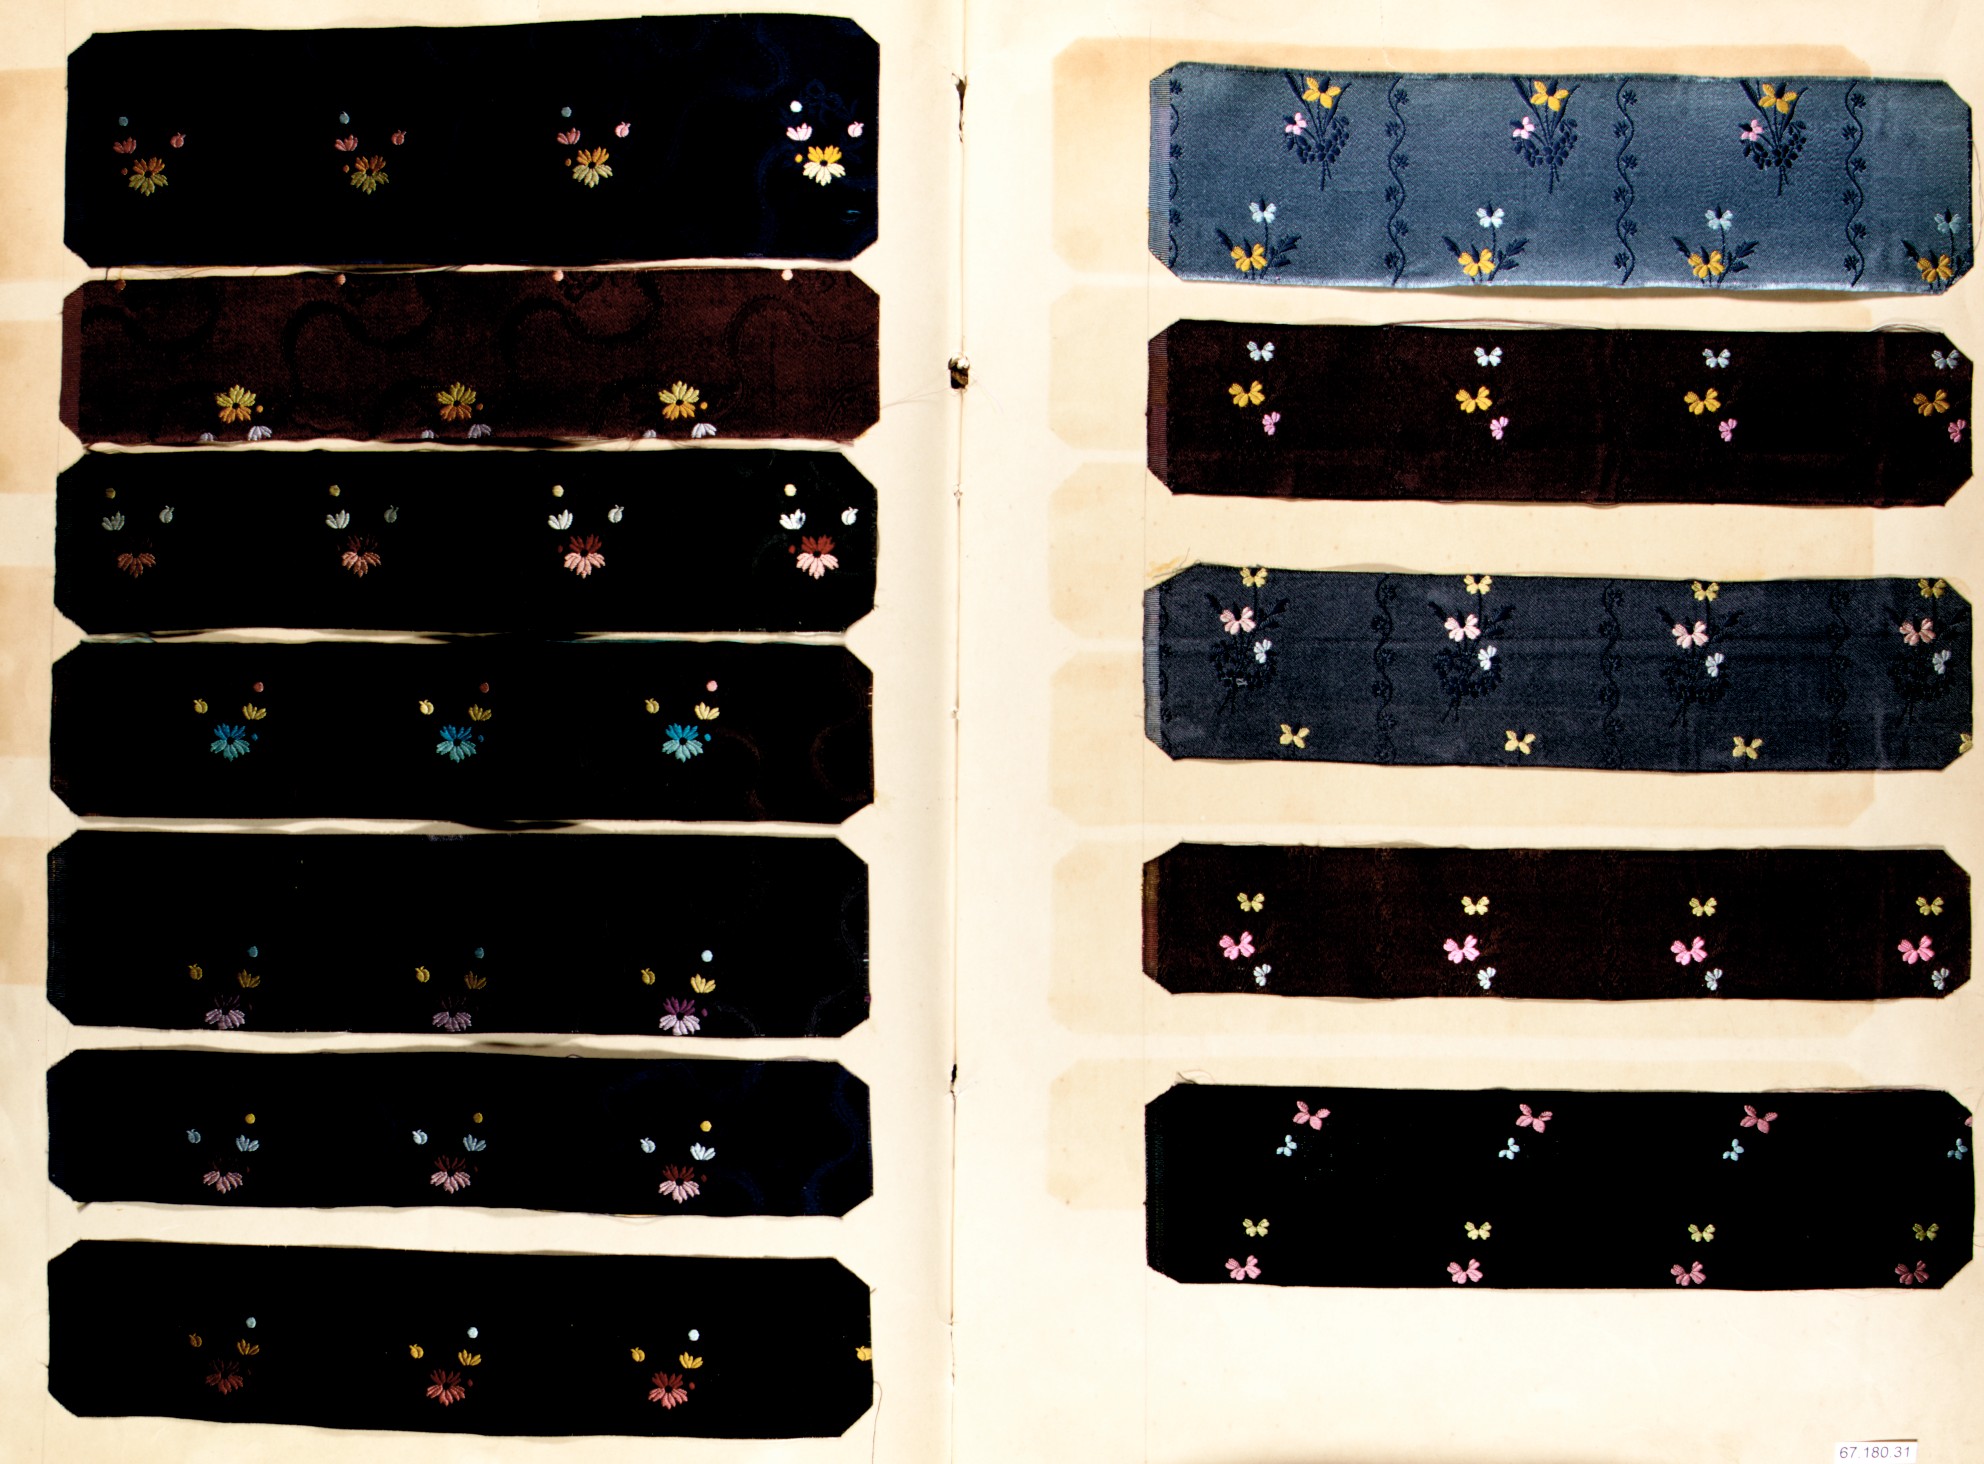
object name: sample book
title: Textile Sample Book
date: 1867-1900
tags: flowers